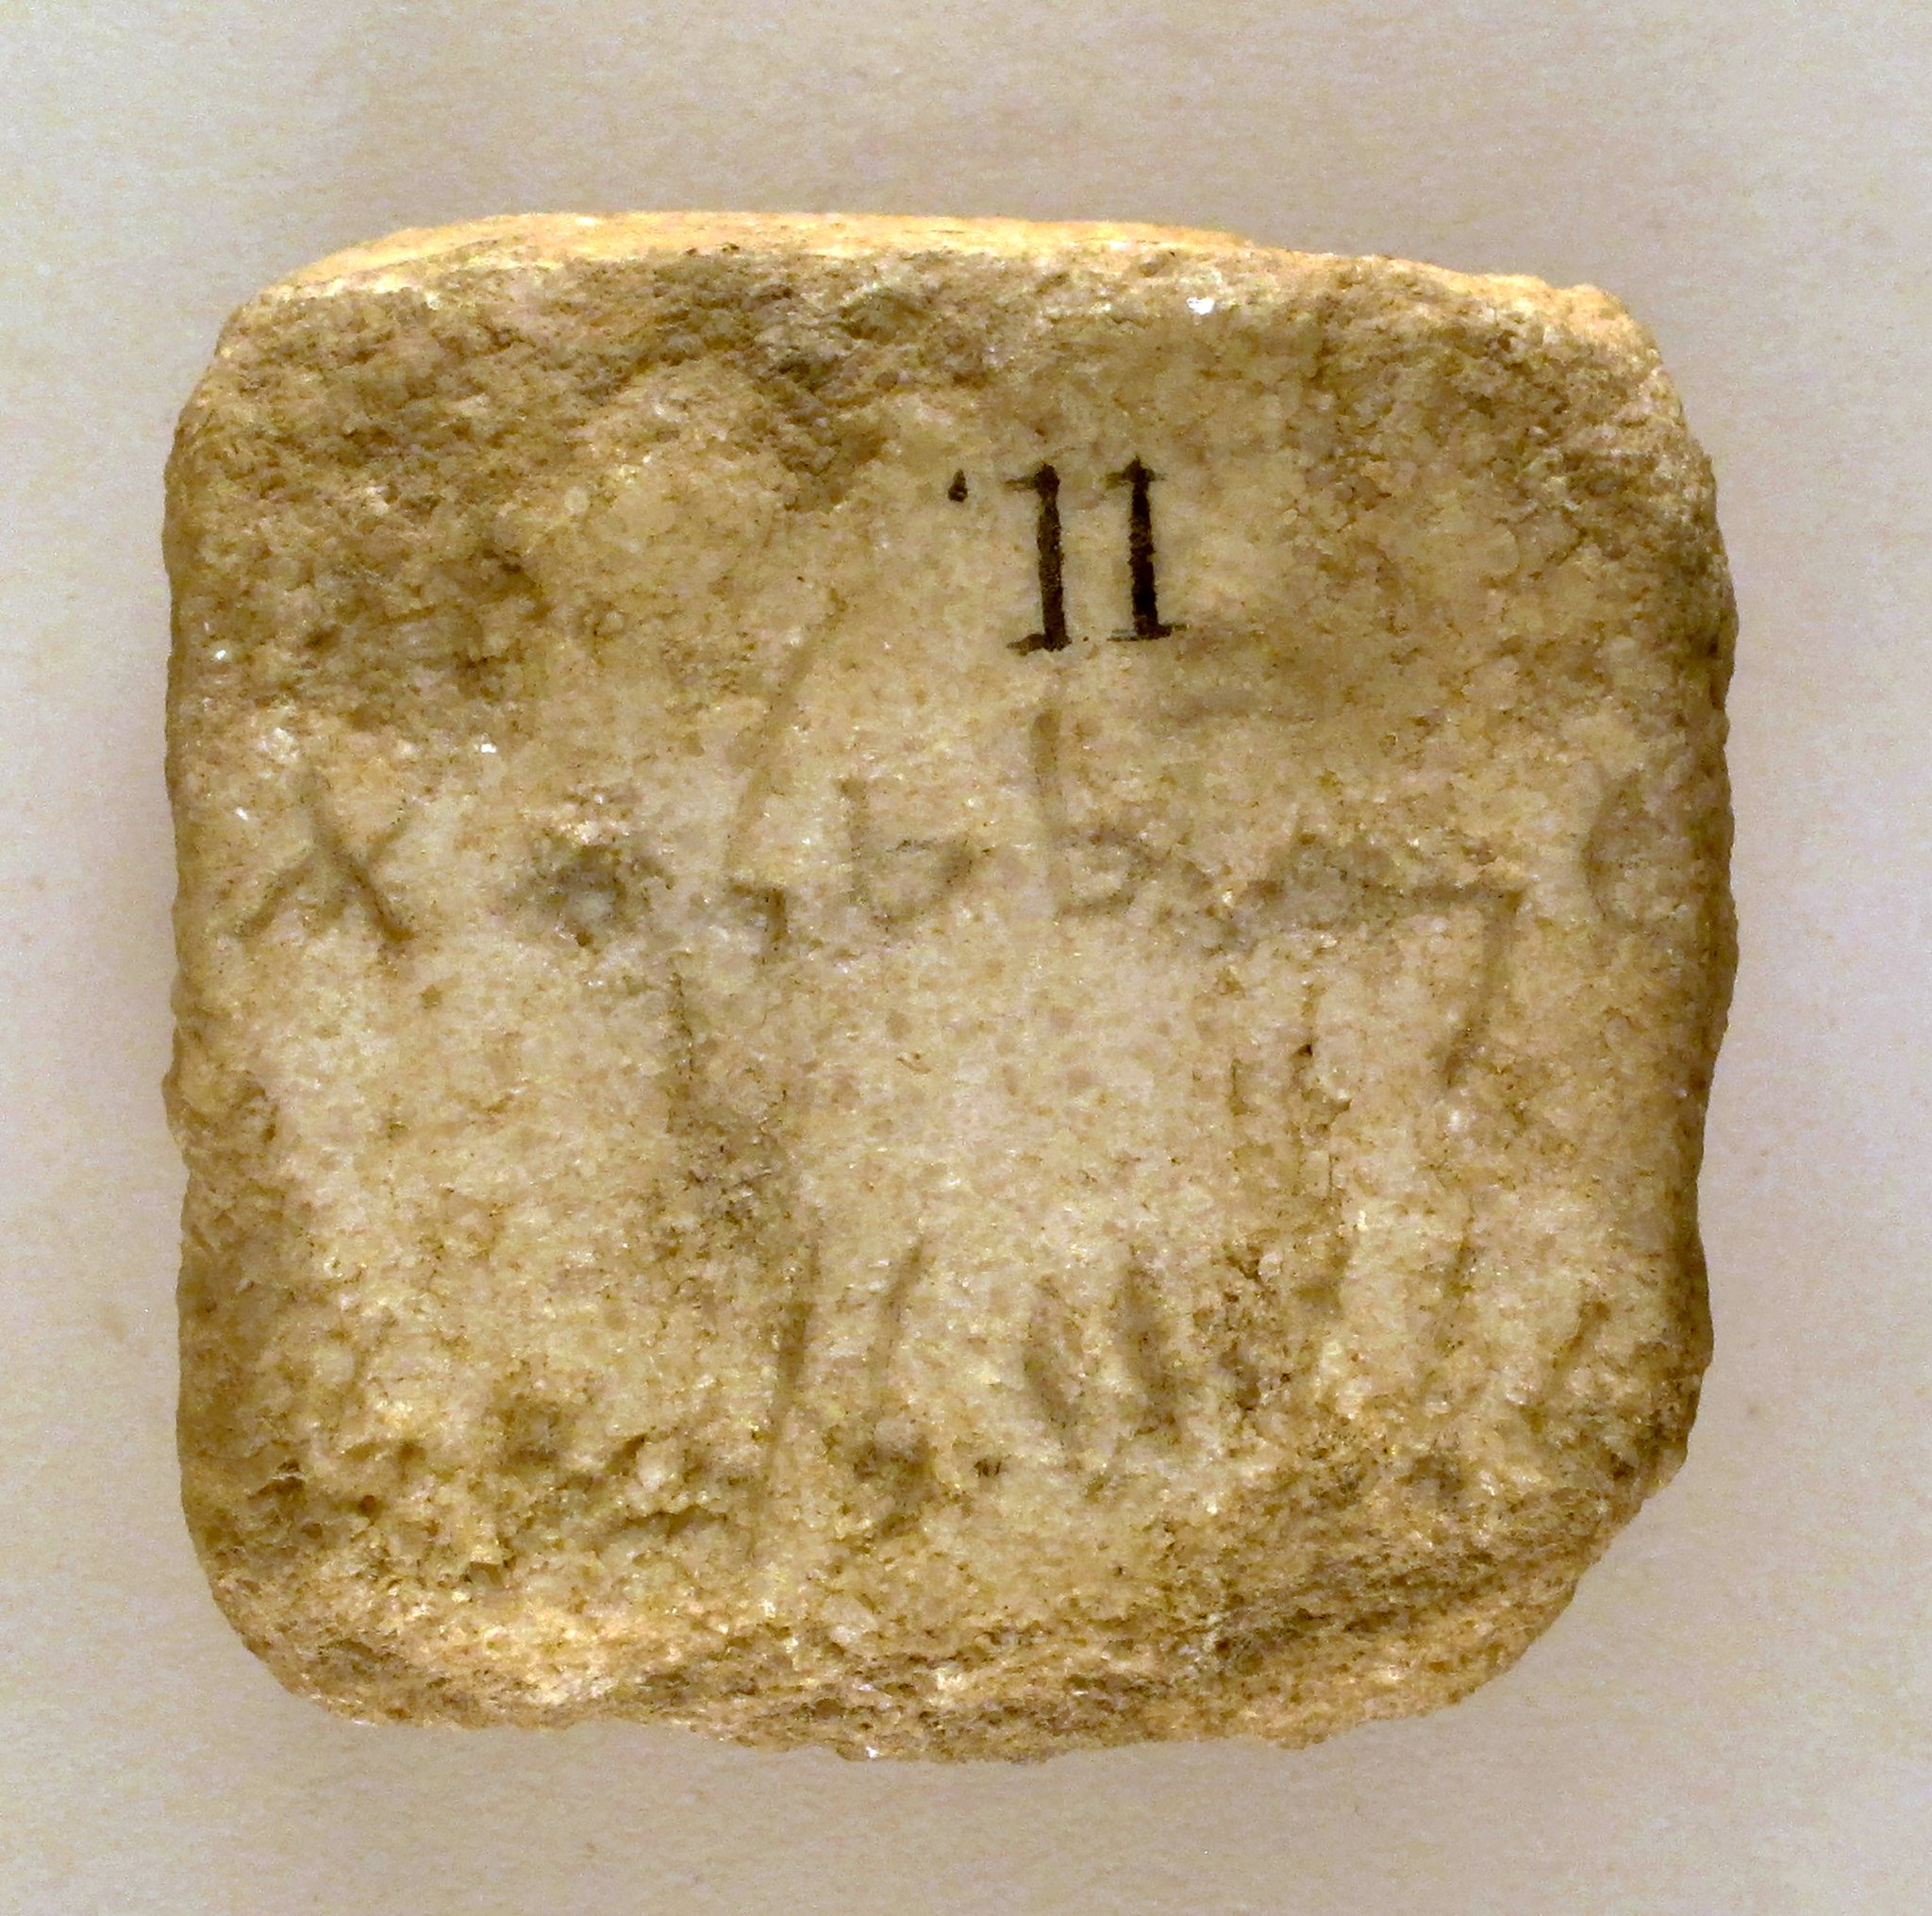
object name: cippus fragment with phoenician inscription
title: Marble cippus fragment with Phoenician inscription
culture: cypriot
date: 400-301 BCE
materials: marble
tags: phoenician